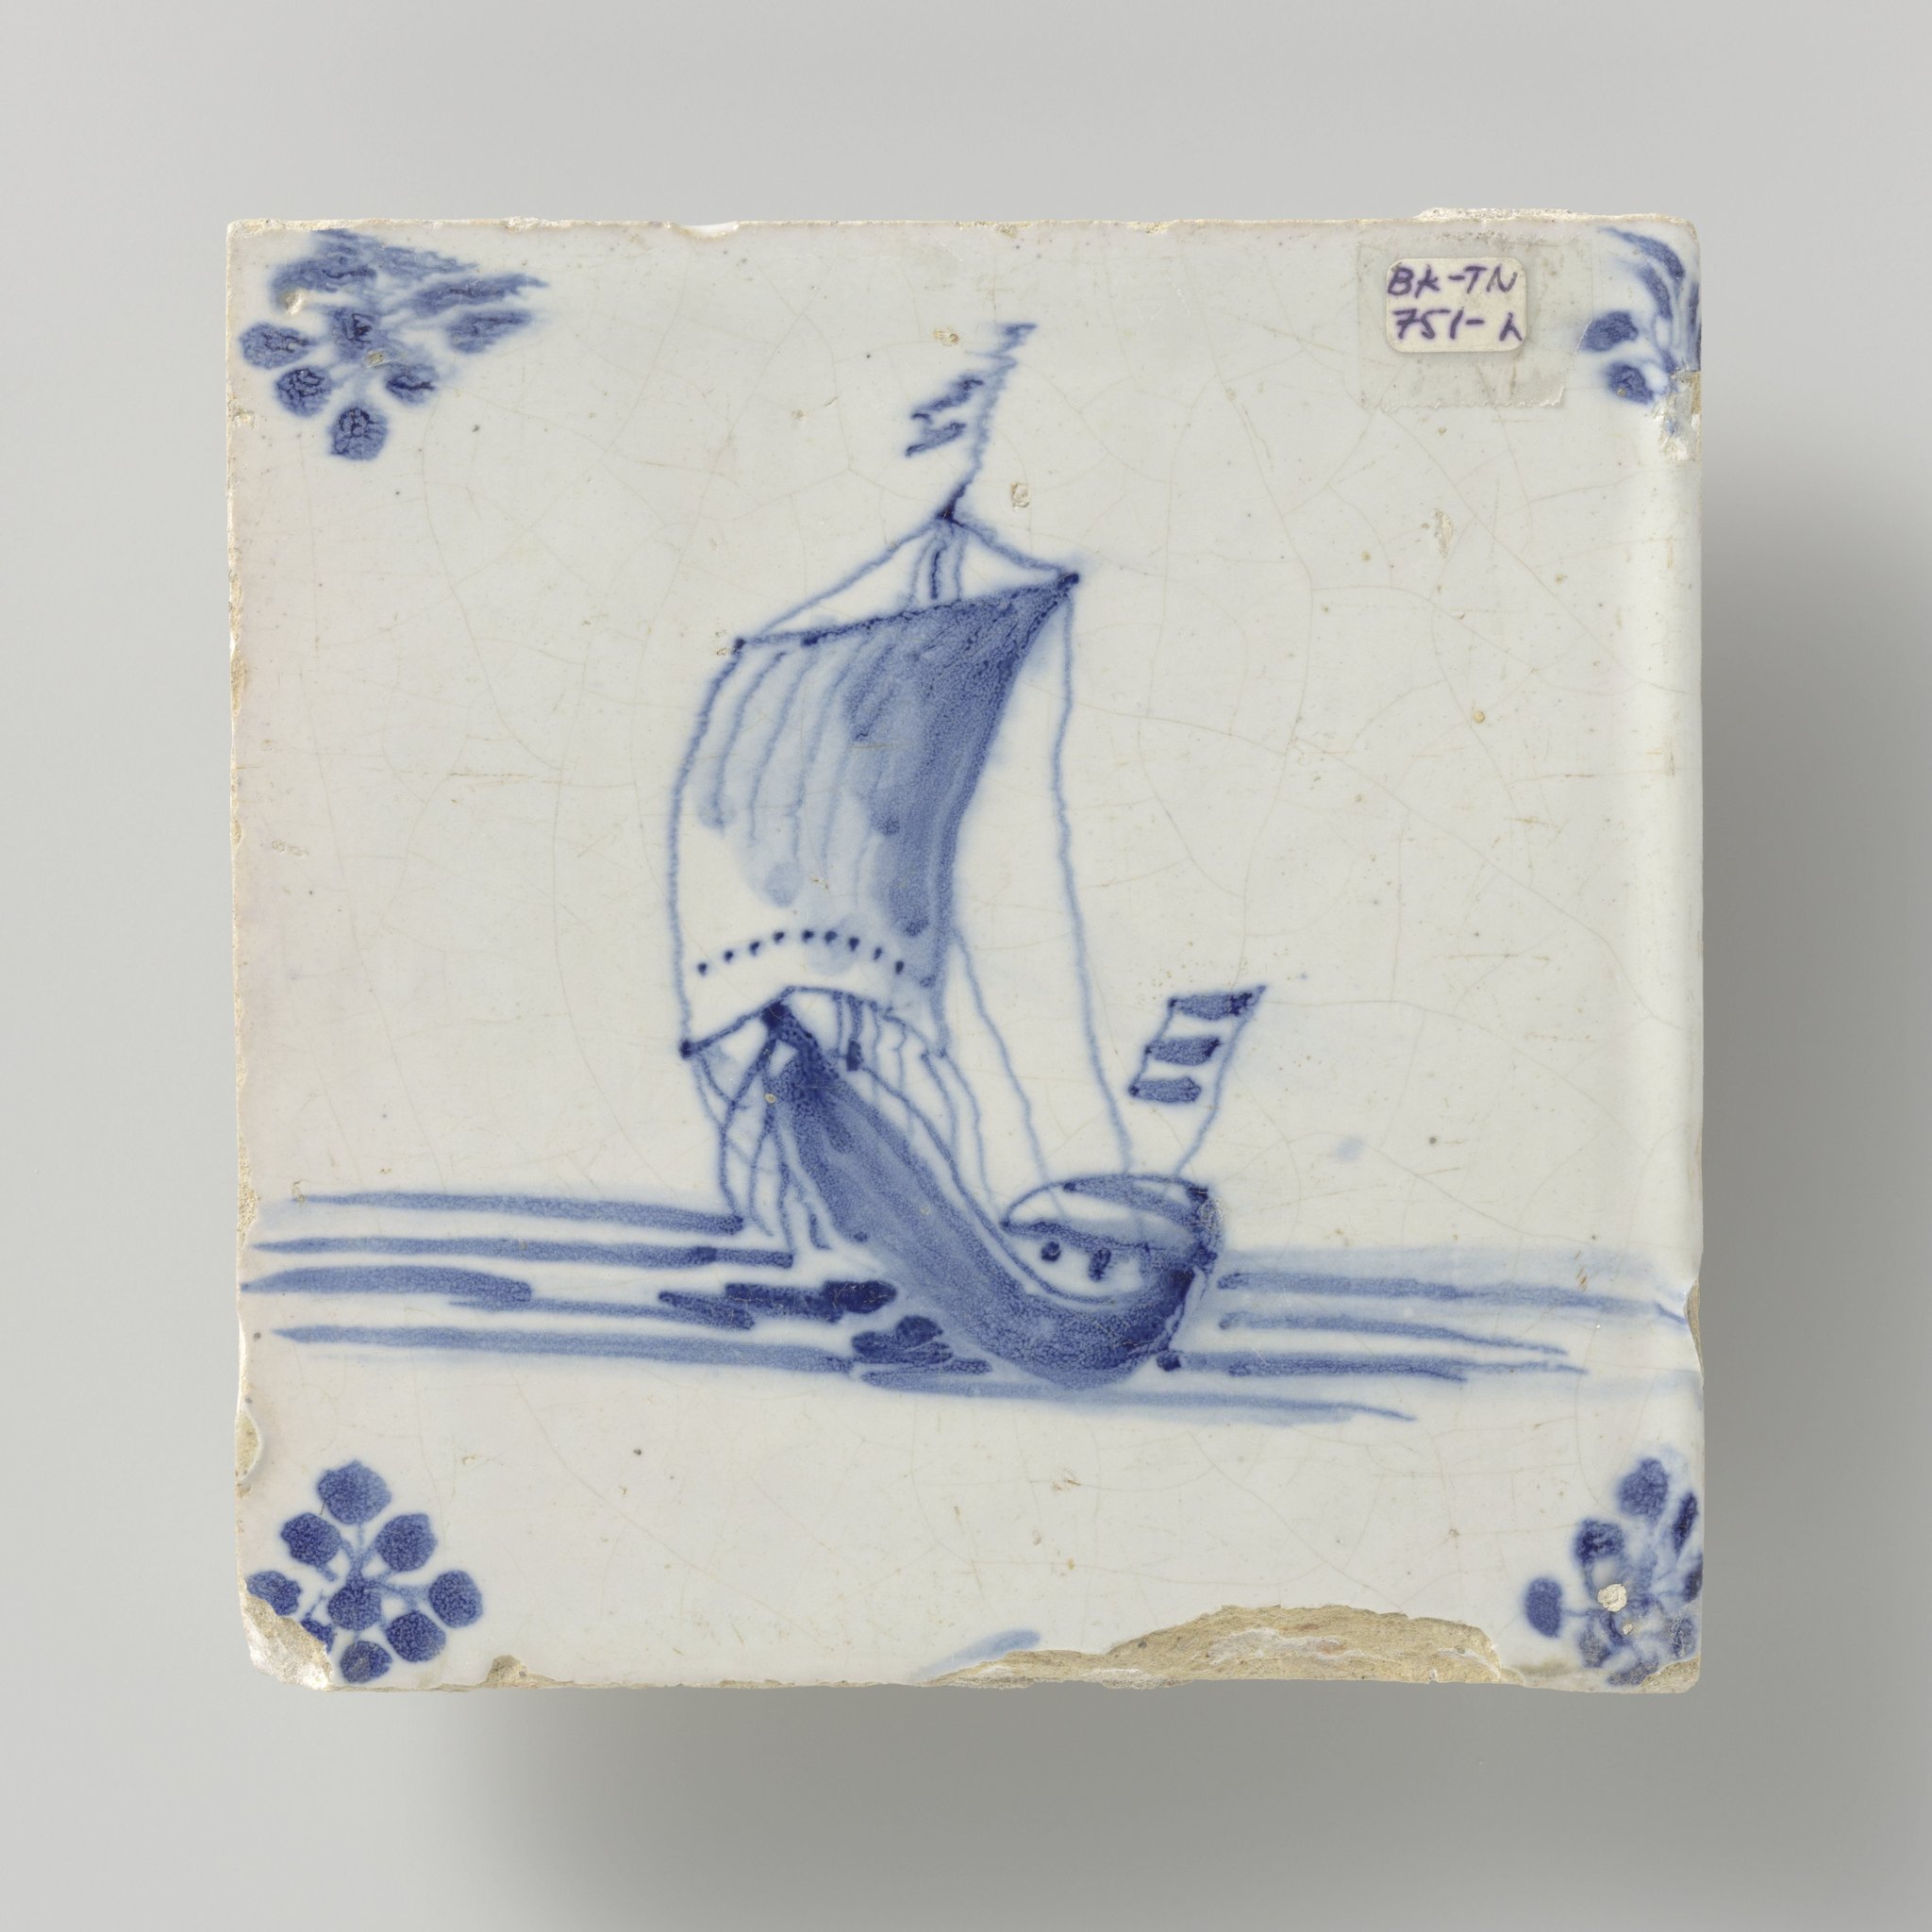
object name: tile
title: Tegel, blauw beschilderd met een schip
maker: Anonymous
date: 1650-1680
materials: earthenware, glaze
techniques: maiolica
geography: netherlands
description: Tegel, blauw beschilderd met een schip, zogenaamd boerenscheepje. In de hoeken een spinnekop.